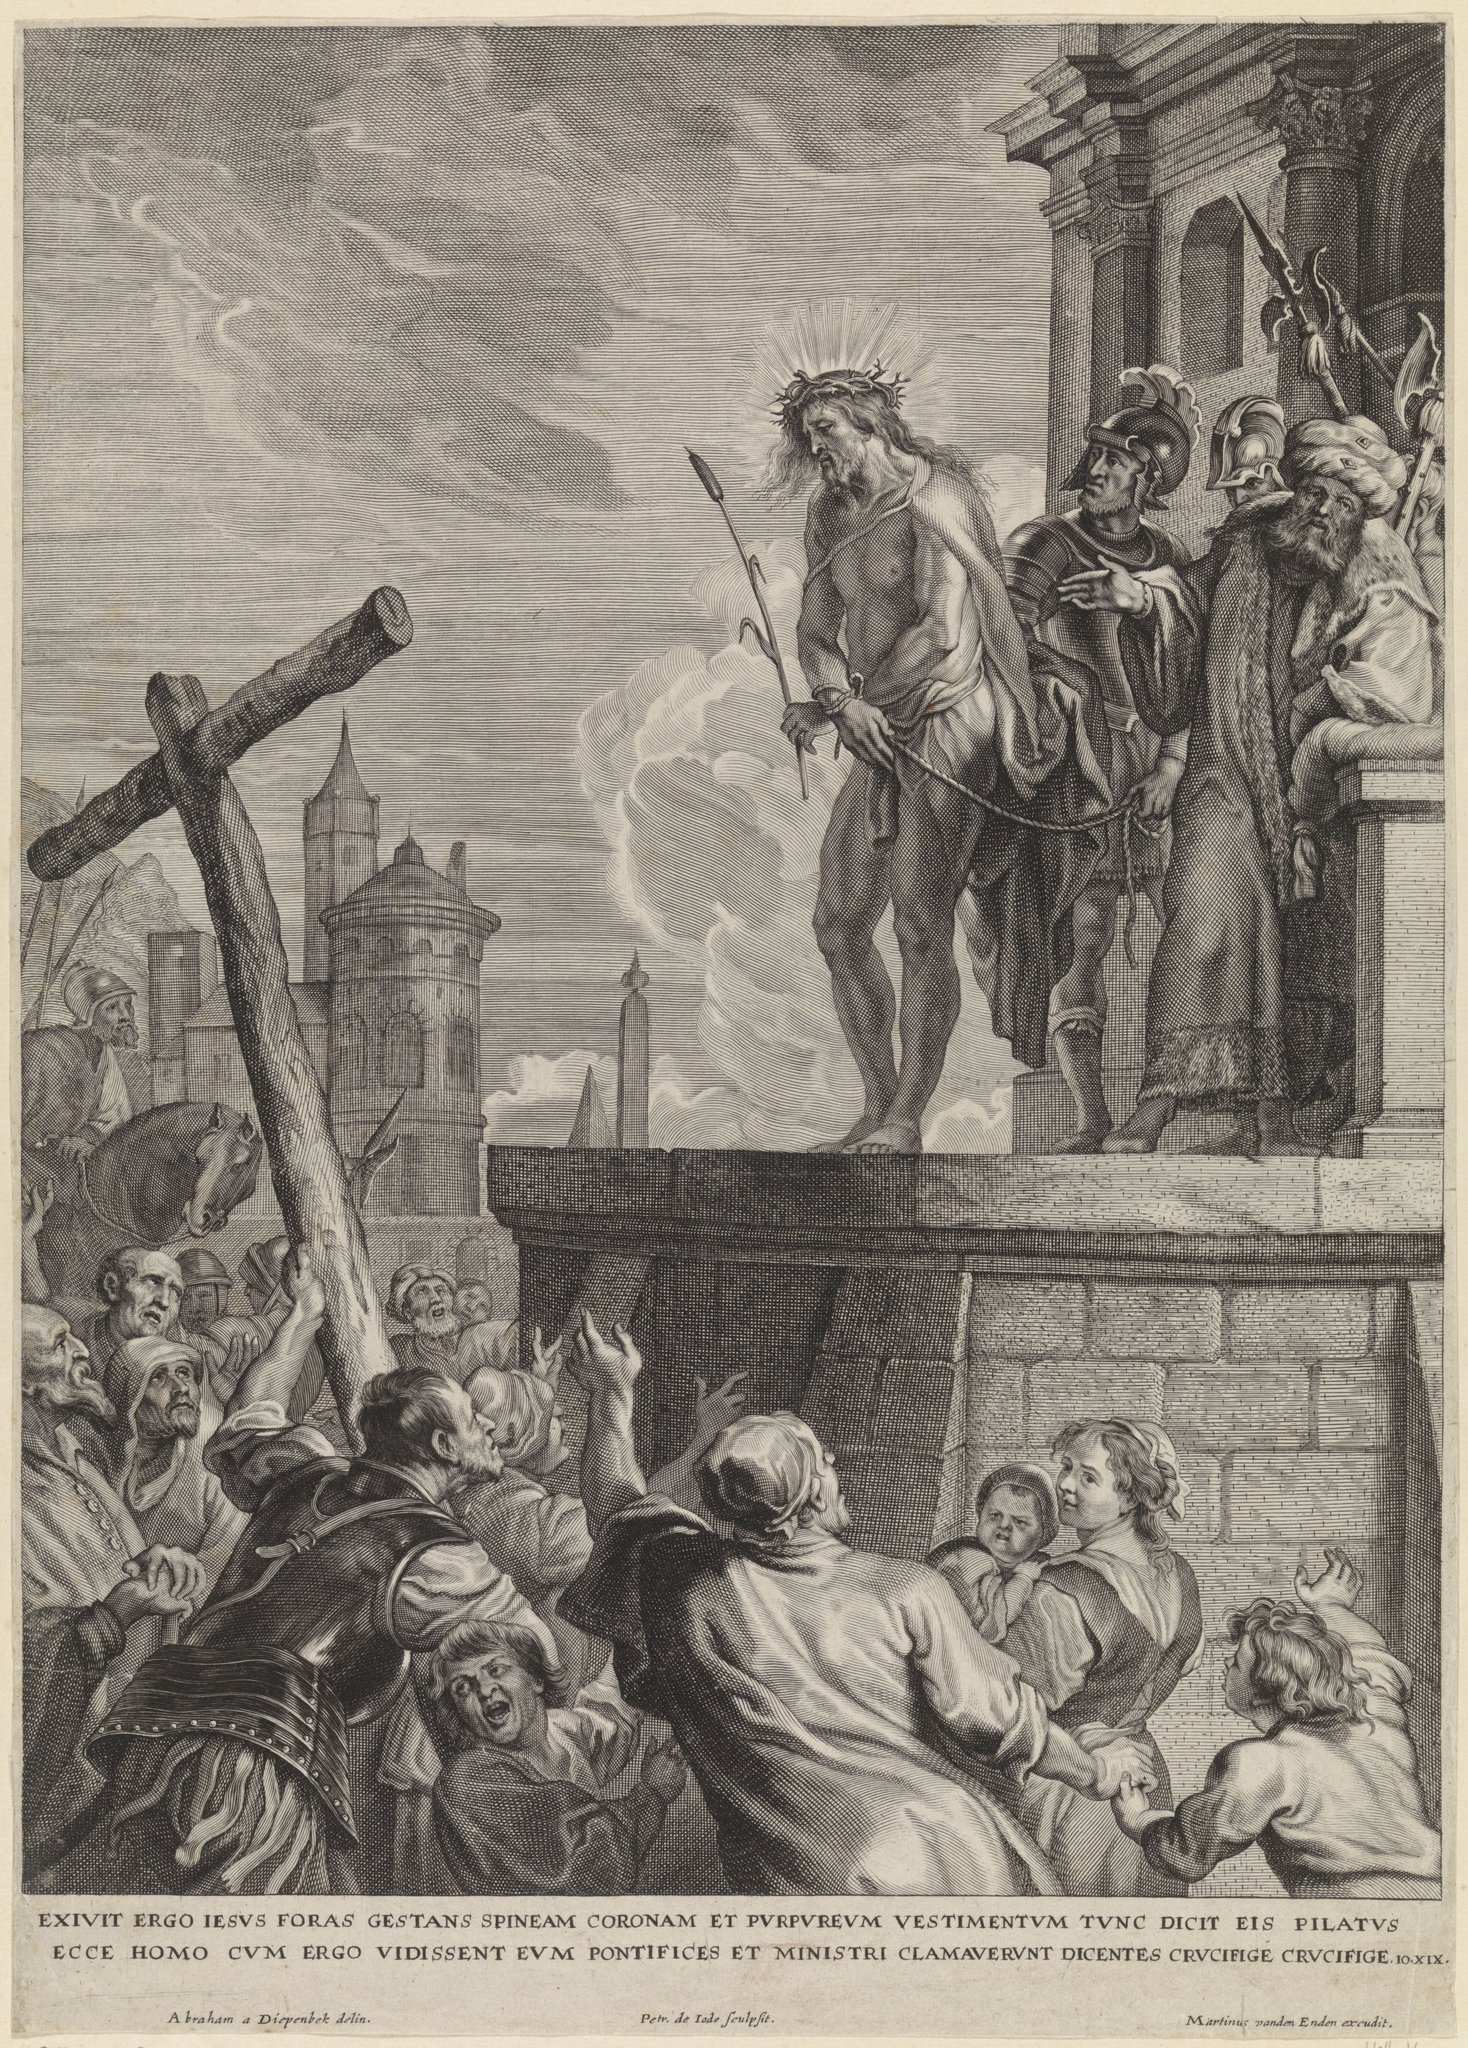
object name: print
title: Christus aan het volk getoond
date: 1628-1670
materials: paper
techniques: engraving, etching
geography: antwerp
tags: pilate showing christ to the people, 'ostentatio christi', 'ecce homo' (john 19:4-6)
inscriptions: collector's mark: Lugt 240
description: Pilatus, staand op het balkon van zijn paleis, toont Christus aan het volk. Christus, met lendendoek, mantel en doornenkroon, houdt een rietstengel vast. De mensen onder het balkon roepen om zijn kruisiging, sommigen hebben hun arm geheven. Links staat een man die het kruis omhoog houdt. In de marge een tweeregelig onderschrift in het Latijn.